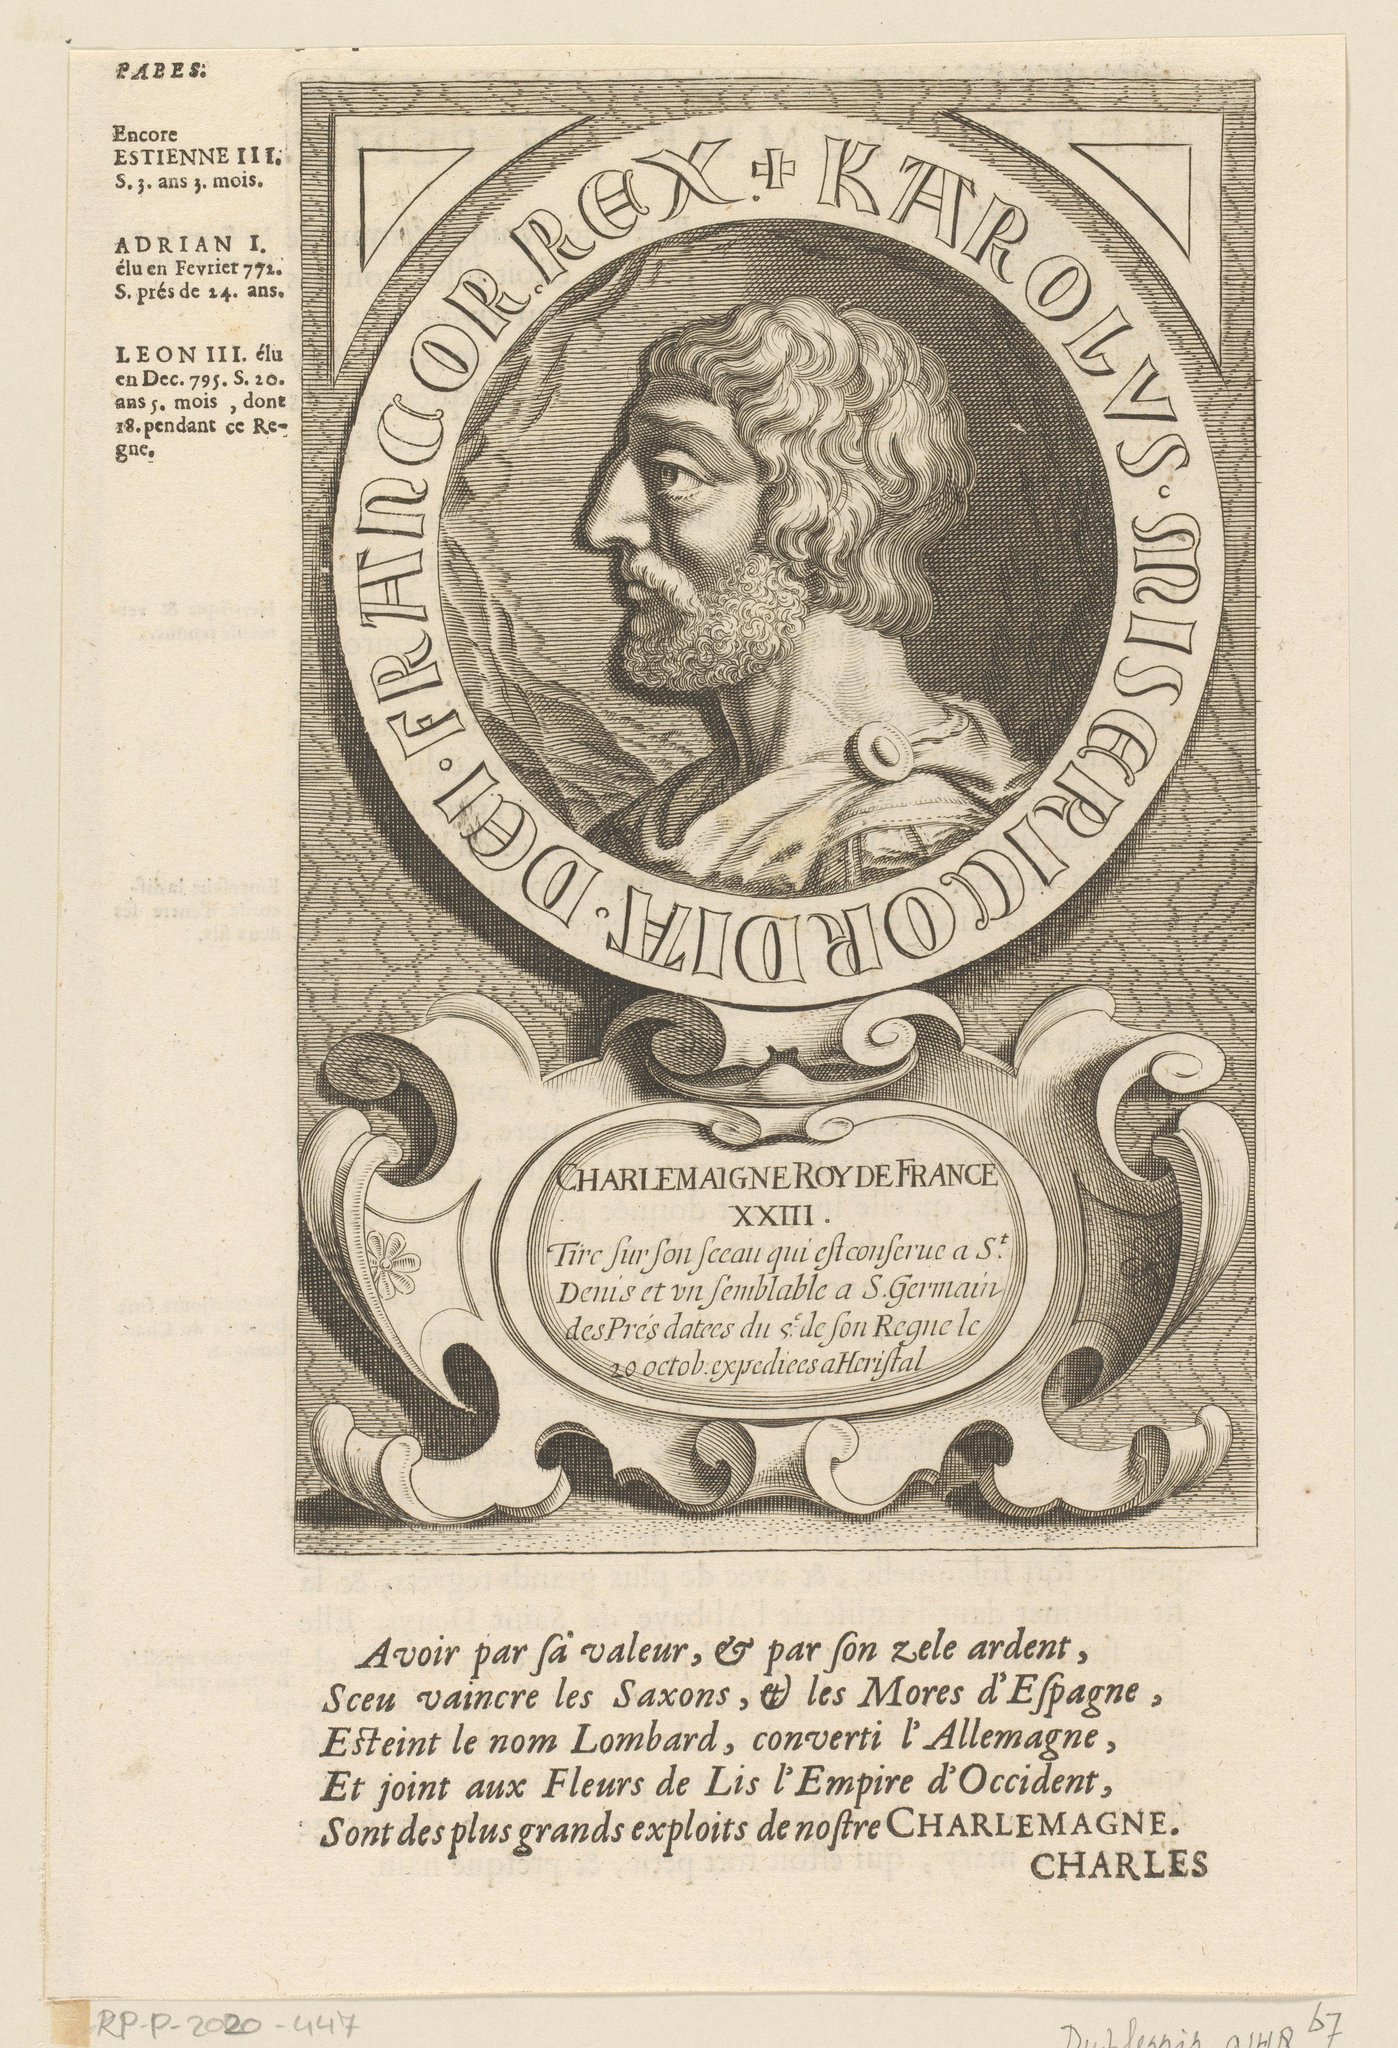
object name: print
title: Portret van Karel de Grote, keizer van het Heilige Roomse Rijk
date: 1635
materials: paper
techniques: engraving, letterpress printing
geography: paris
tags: charlemagne (holy roman emperor), historical persons, ruler, sovereign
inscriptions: collector's mark: Lugt 2228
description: Prent uit: Eudes de Mézeray, François. Histoire de France, depuis Faramond jusqu’au regne de Louis le Juste (...). 3 dln. Parijs: Denis Thierry, Jean Guignard en Claude Barbin, 1635, dl. 1. Prent waarschijnlijk voor het eerst verschenen in: Bie, Jacques de. Les vrais portraits des rois de France (...). Parijs: Jacques de Bie en Pierre Rocolet, 1634. Prent ook gebruikt in latere publicaties.